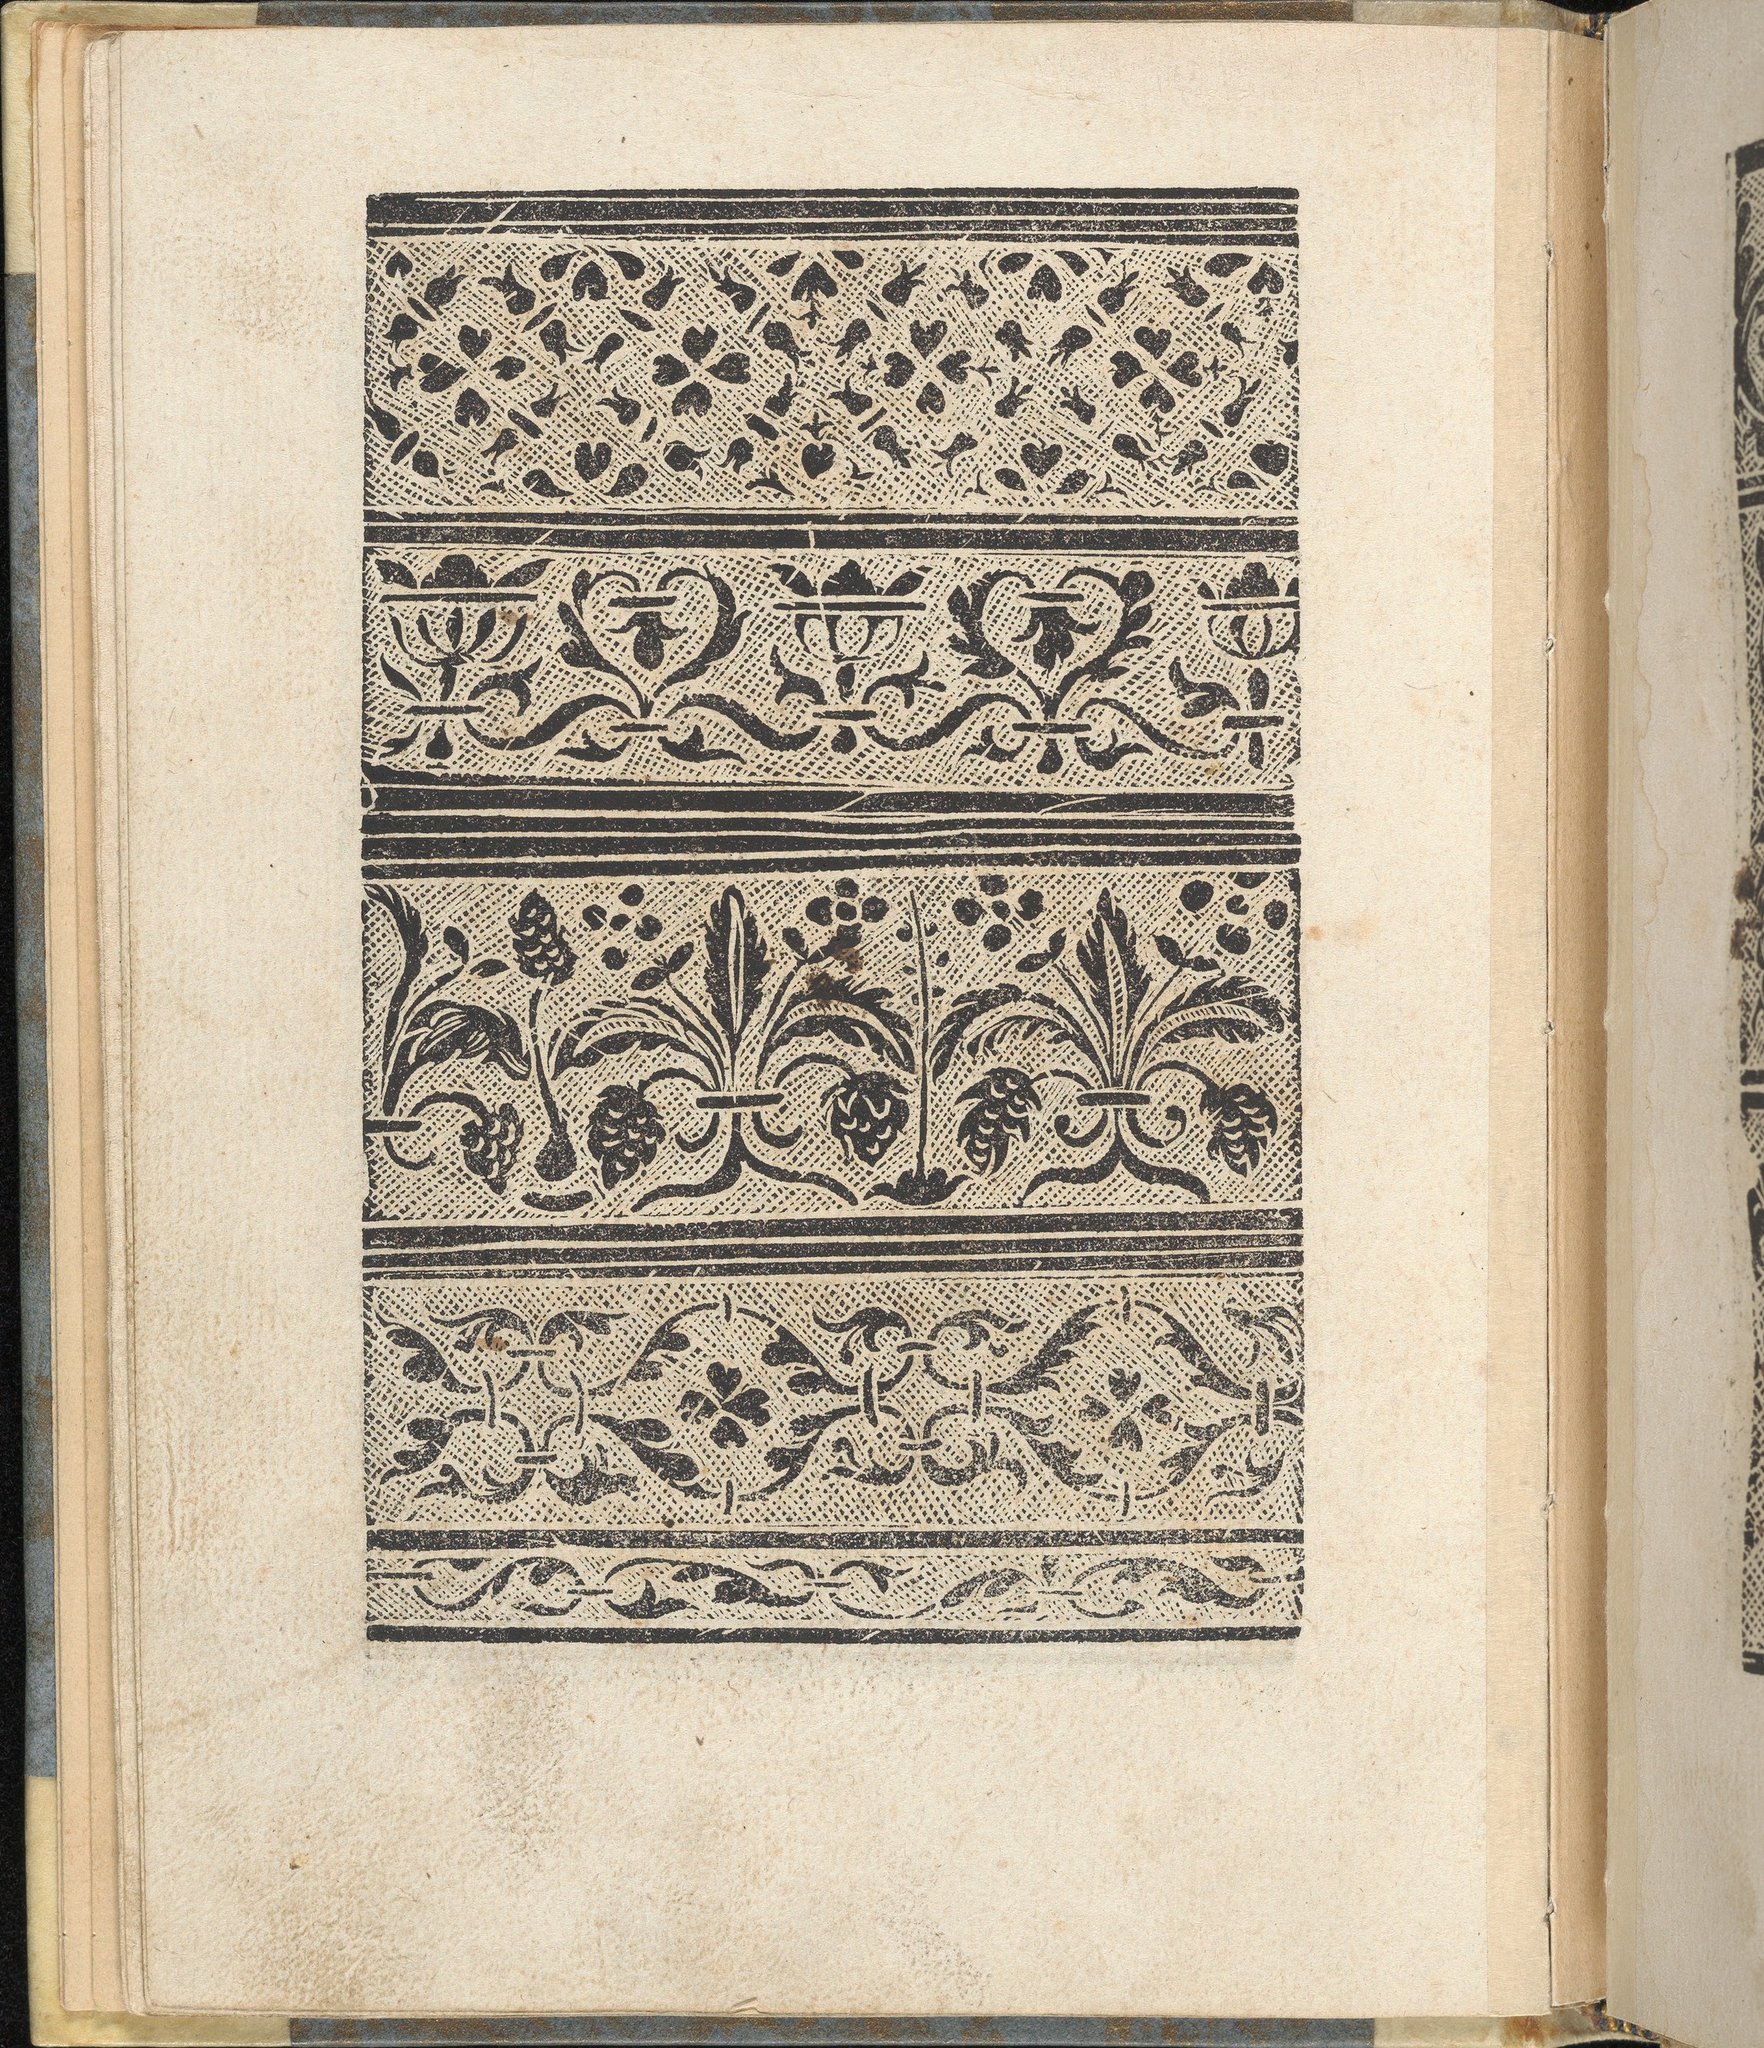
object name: book print ornament architecture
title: Ein ney Furmbüchlein, Page 14, verso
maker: johann schönsperger the younger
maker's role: publisher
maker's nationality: german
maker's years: 1490-1550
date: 1525-1529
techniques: woodcut